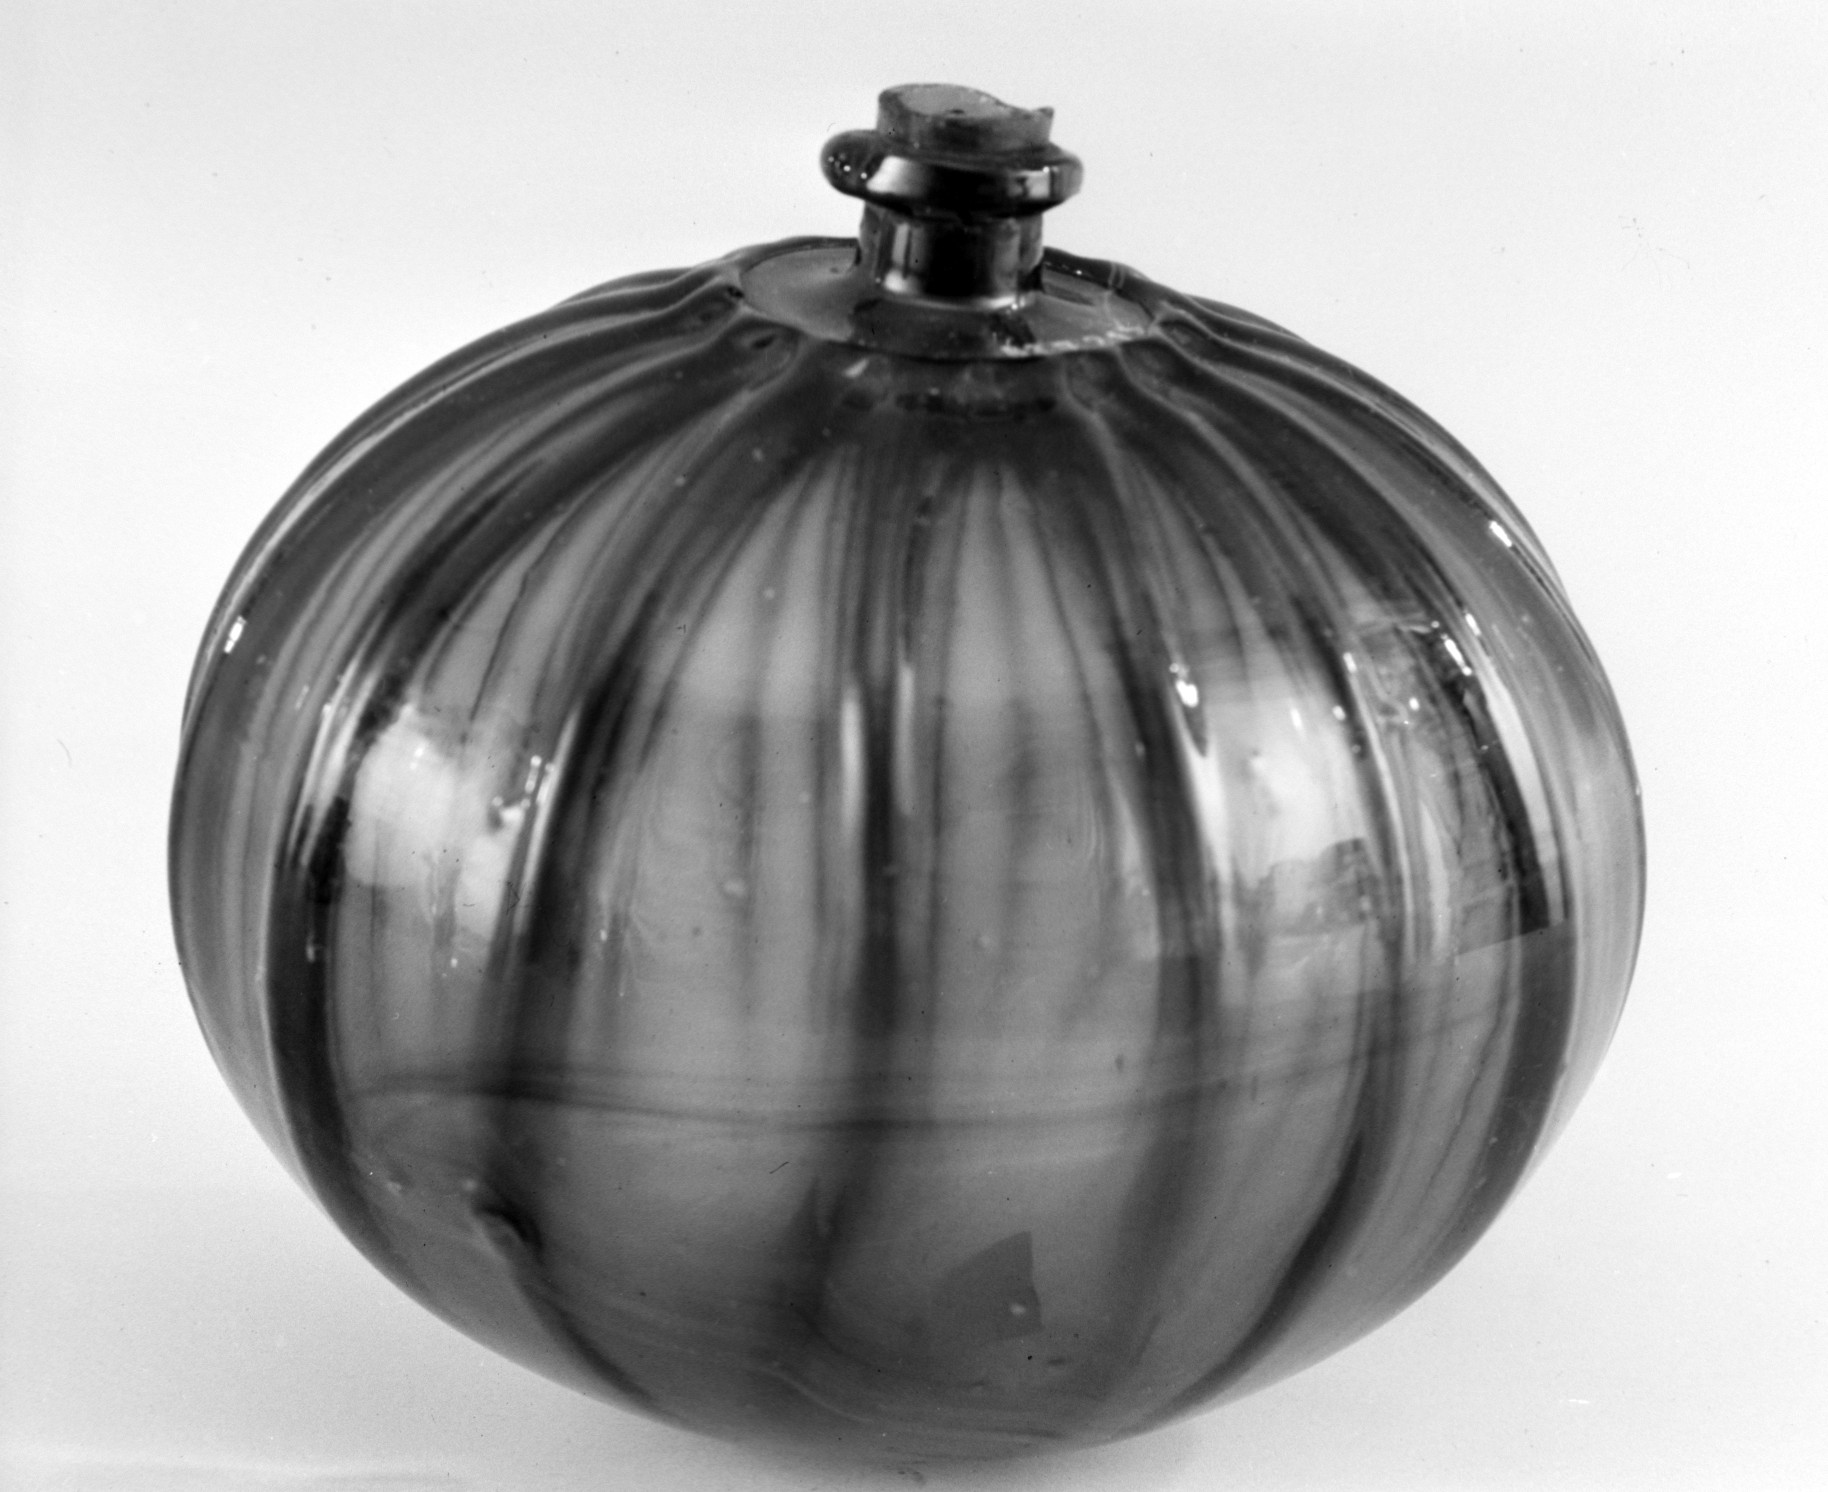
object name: flask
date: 1667-1700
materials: glass